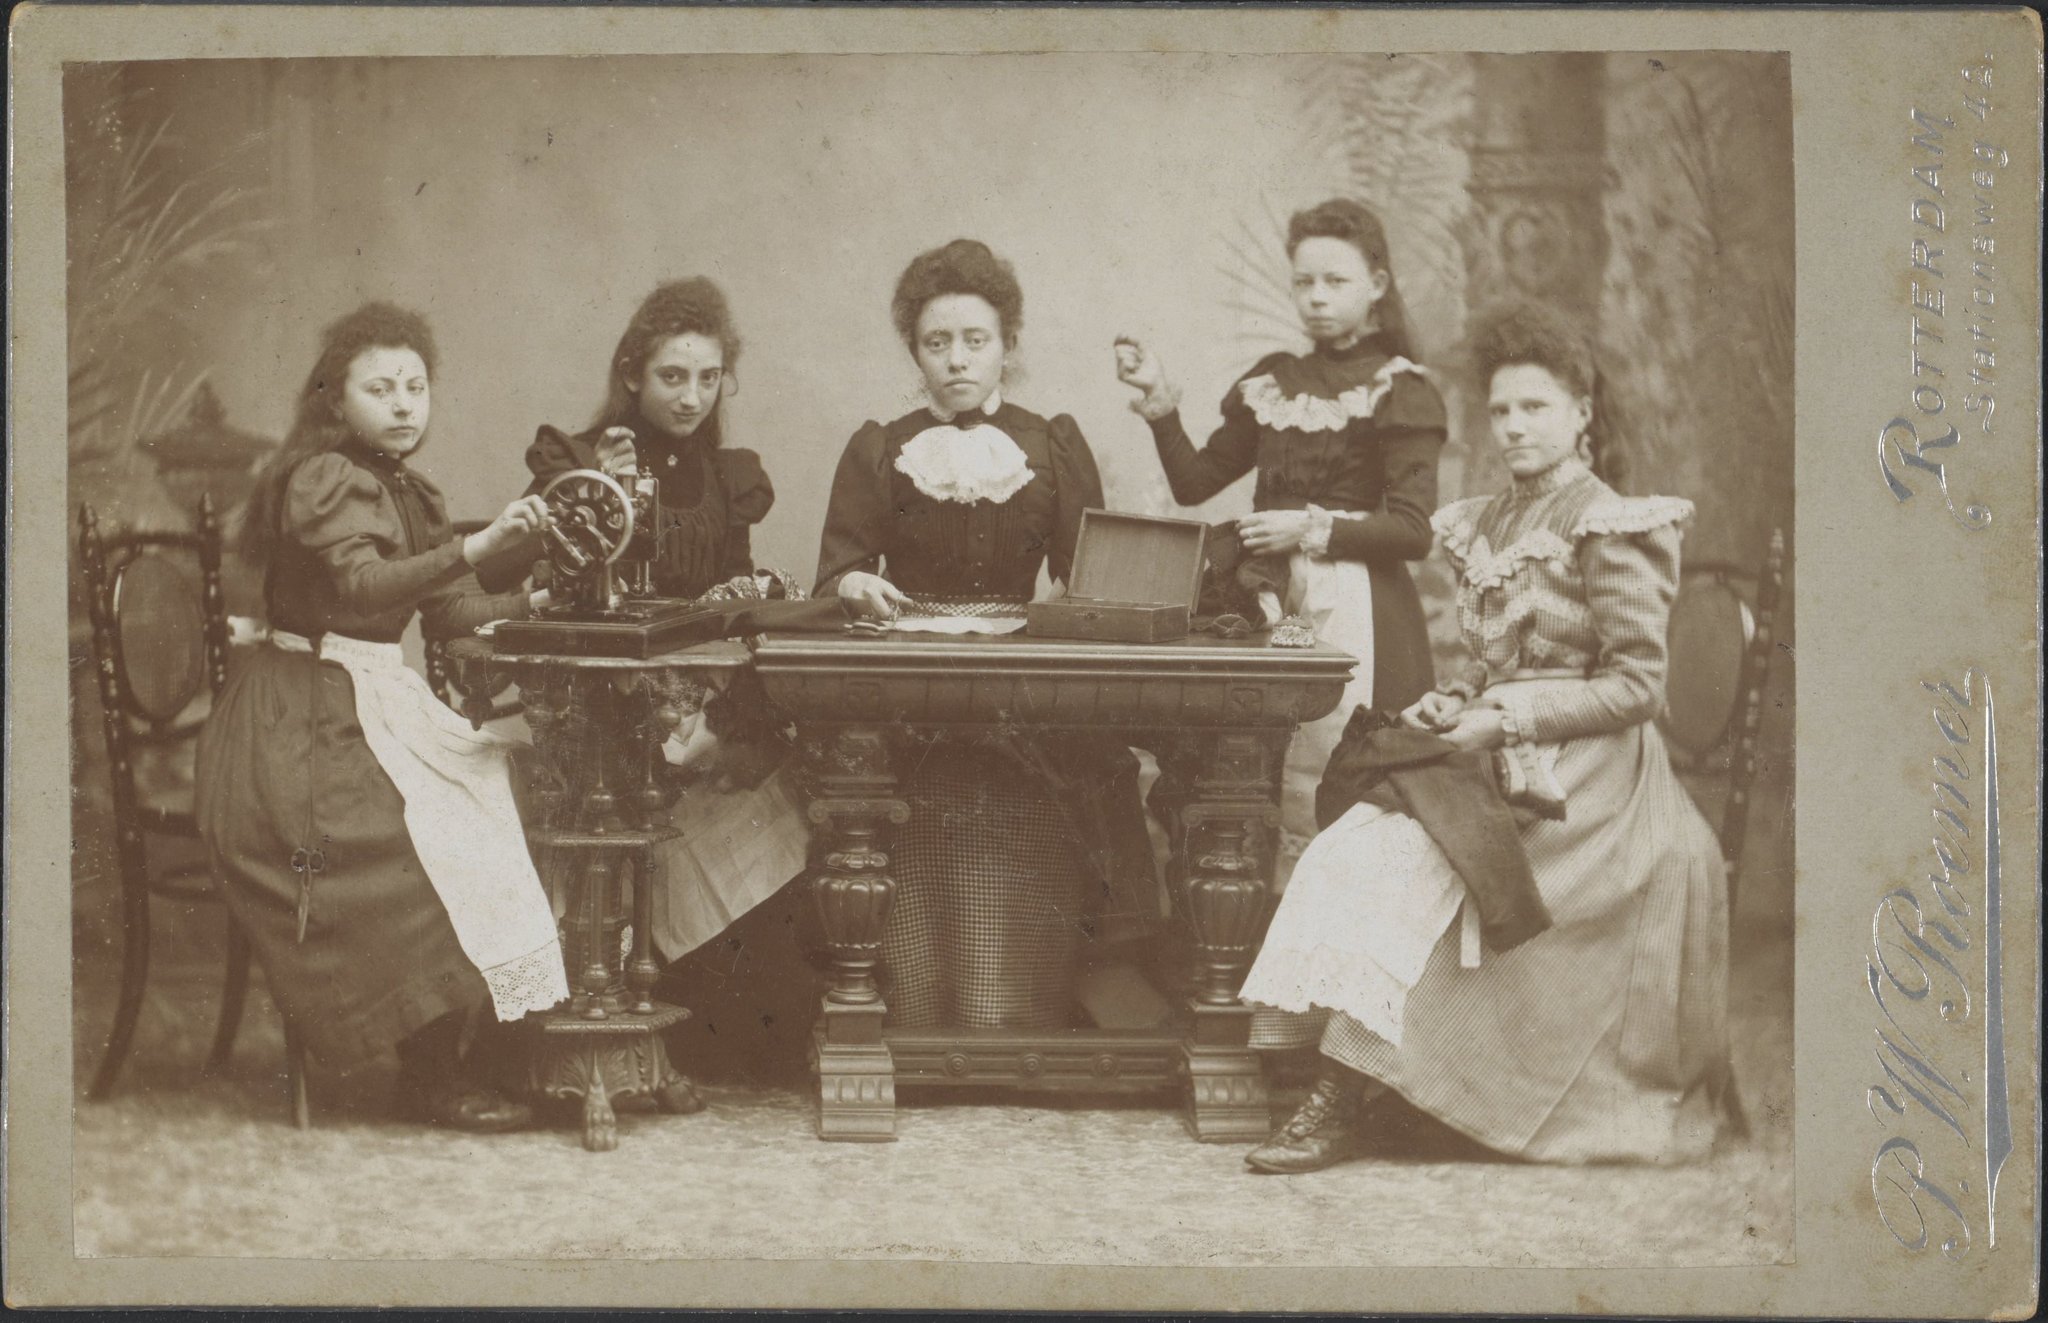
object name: photograph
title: Portret van vijf naaiende vrouwen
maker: pieter wilhelmus roemer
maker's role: fotograaf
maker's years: 1838-1924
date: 1890-1910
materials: cardboard, paper, photographic support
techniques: collodion silver print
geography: rotterdam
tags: studio requisites ~ photographer, historical persons not known by name - bb - woman, home sewing; repair of clothes, rotterdam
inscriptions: address: ‘Rotterdam Stationsweg 42’